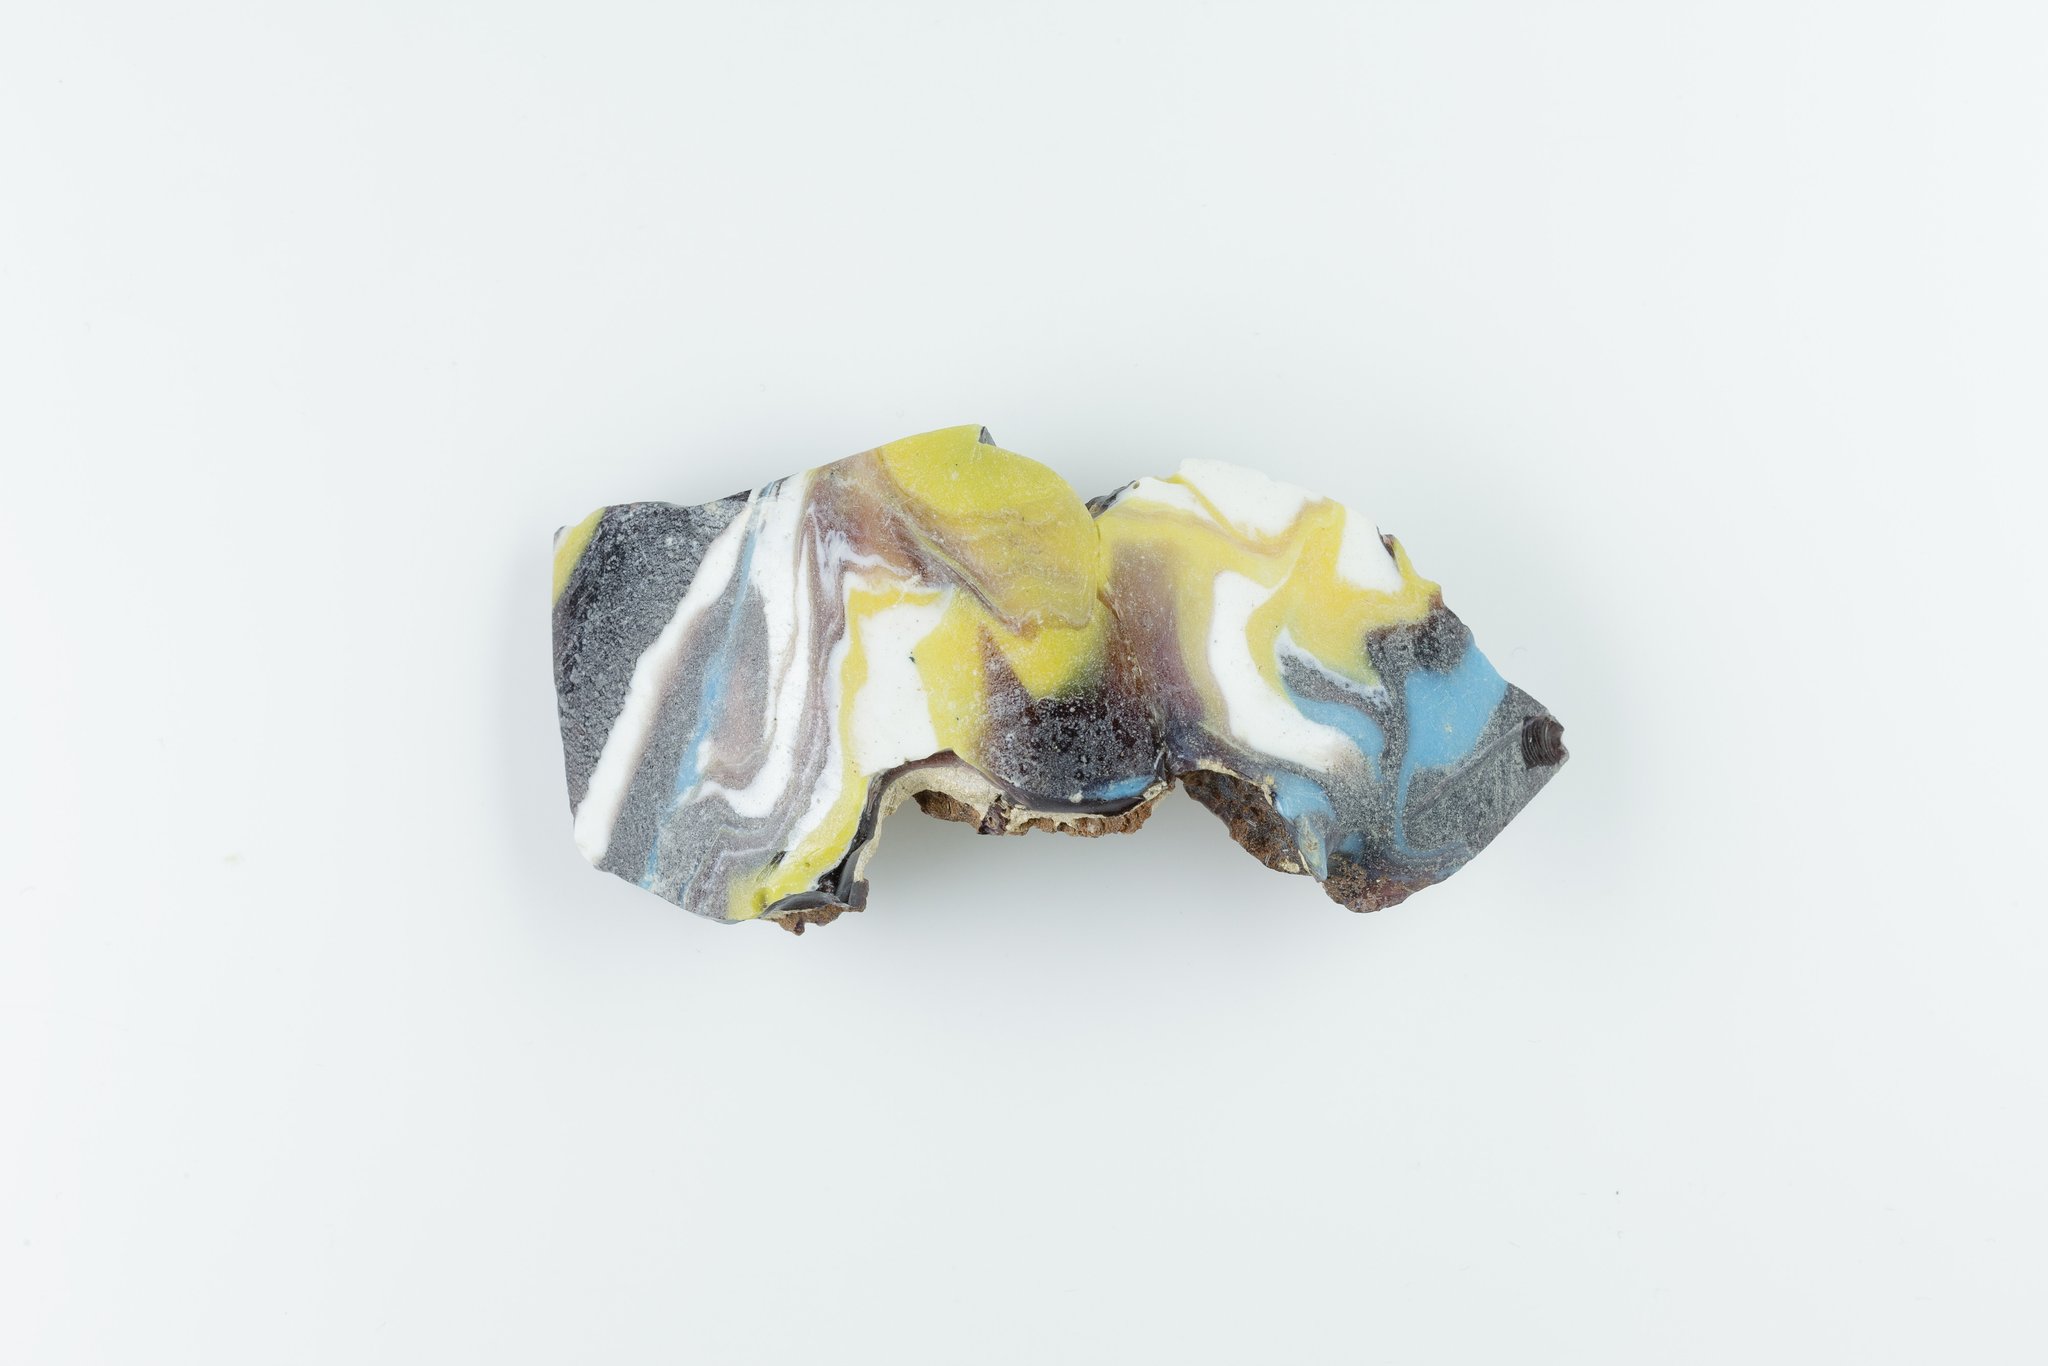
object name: vessel fragment, marbled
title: Fragment from Thick Walled Marbled Vessel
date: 1427-1400 BCE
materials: glass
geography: egypt